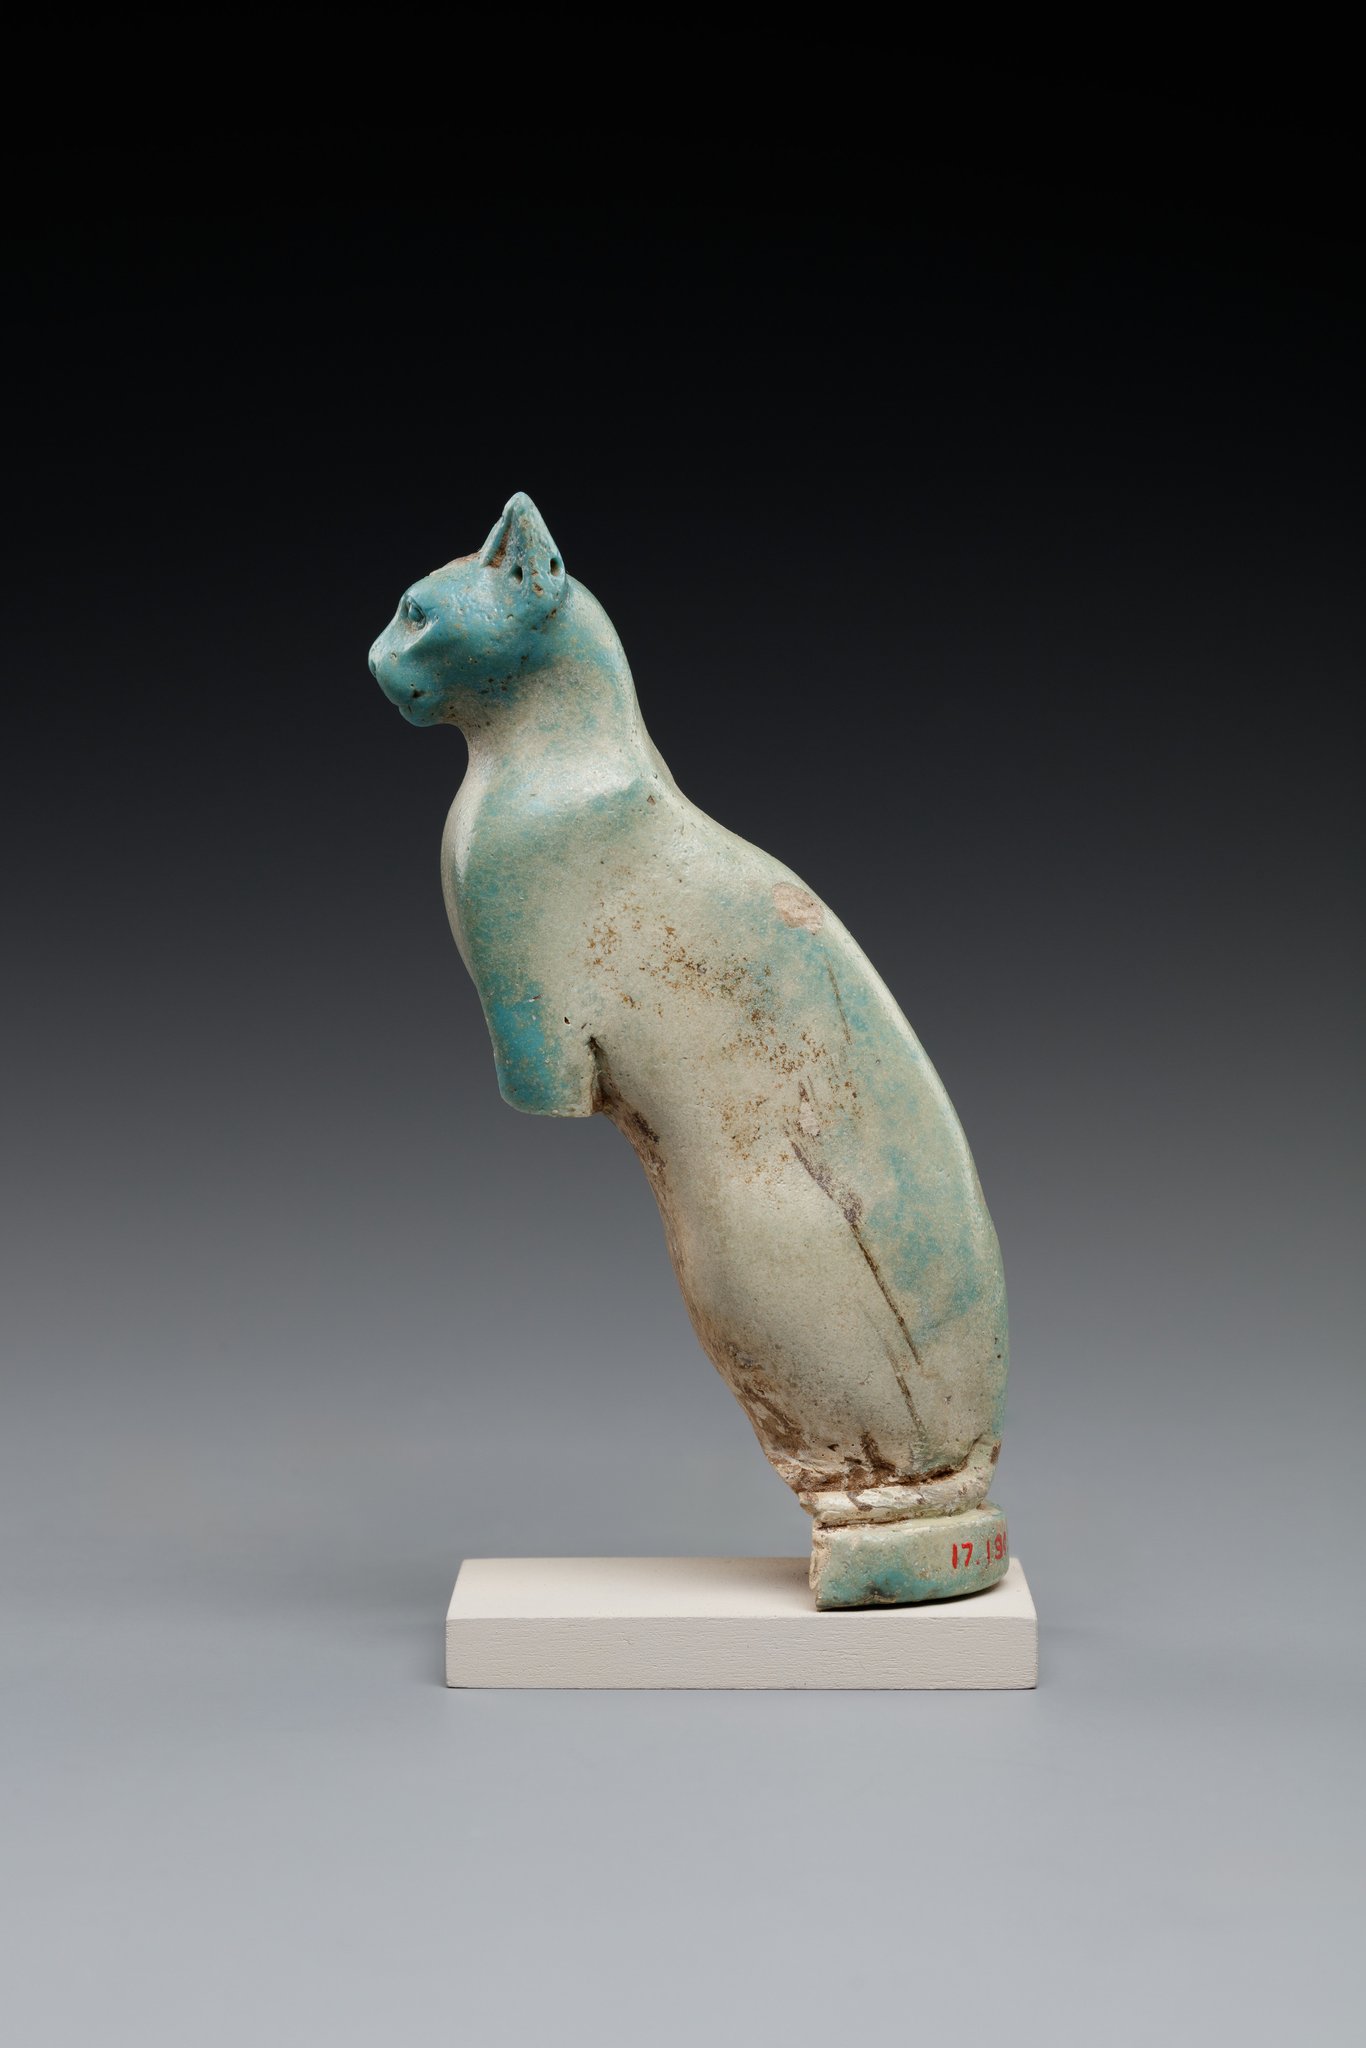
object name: amulet, cat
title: Cat amulet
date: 664-332 BCE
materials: faience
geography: egypt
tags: cats